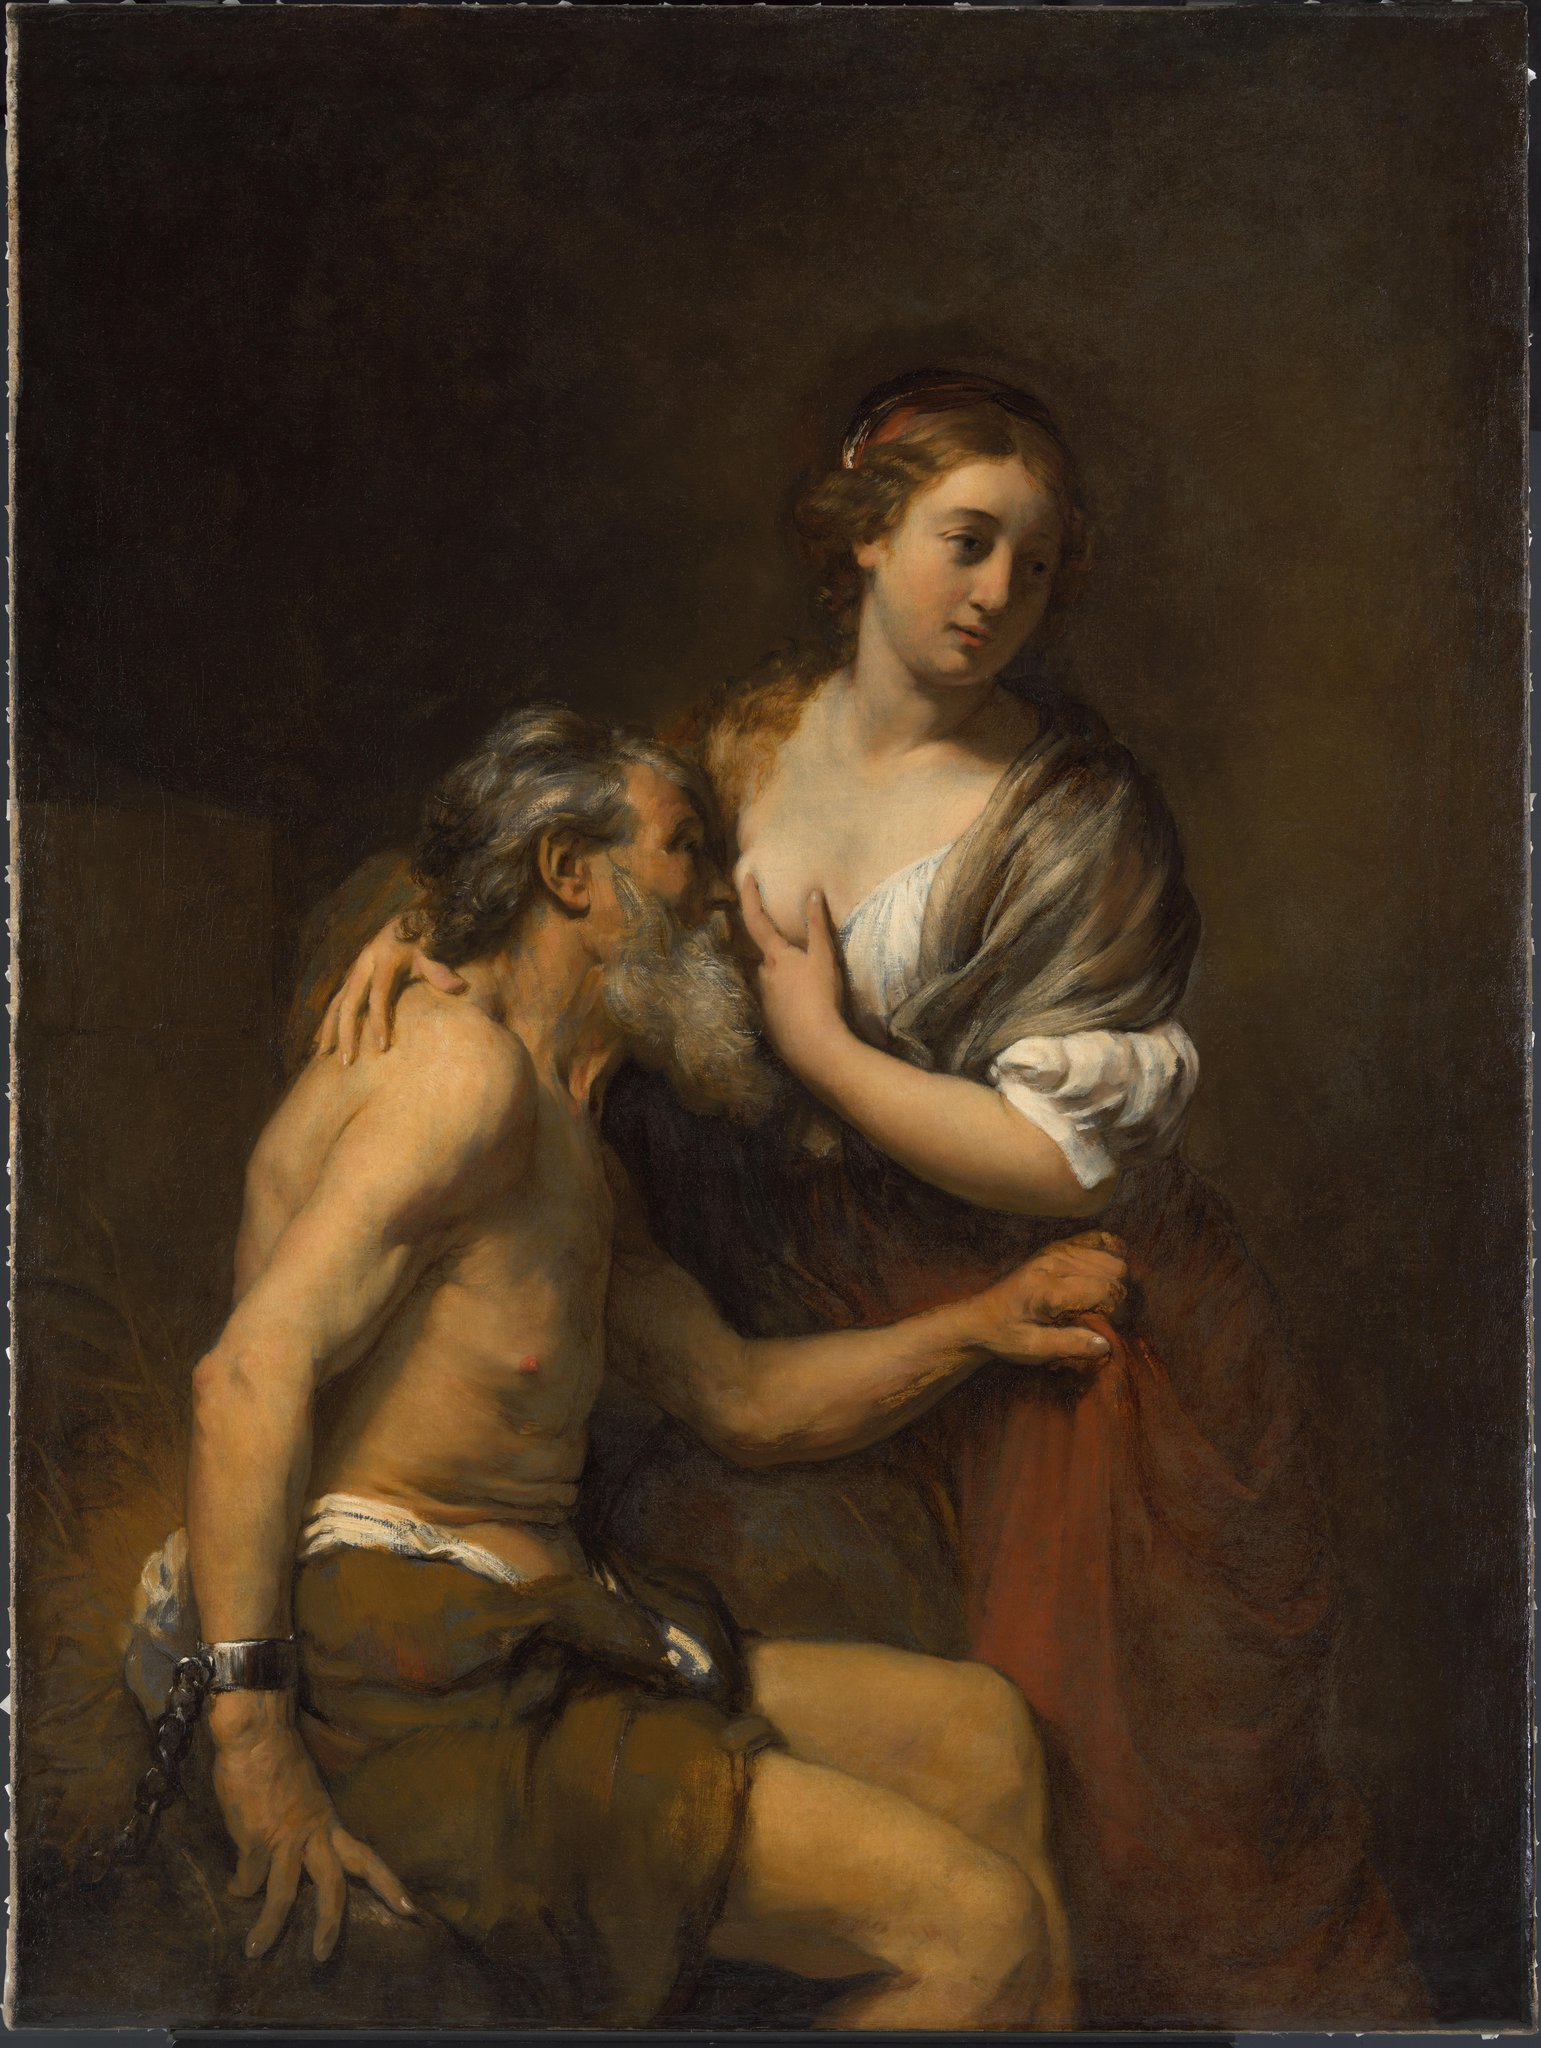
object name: painting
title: Cimon and Pero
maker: willem drost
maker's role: draughtsman, painter, print maker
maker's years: 1633-1659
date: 1655-1657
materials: canvas, oil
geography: venice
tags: pero suckling cimon ('caritas romana')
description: Pero secretly breastfeeds her father Cimon in prison, sustaining him when he was sentenced to death by starvation. Pero thus kept him alive and he was eventually pardoned. This story from Roman antiquity is about ultimate charity and self-sacrifice. The painting is a rare masterpiece by the young and short-lived Rembrandt pupil, Willem Drost.